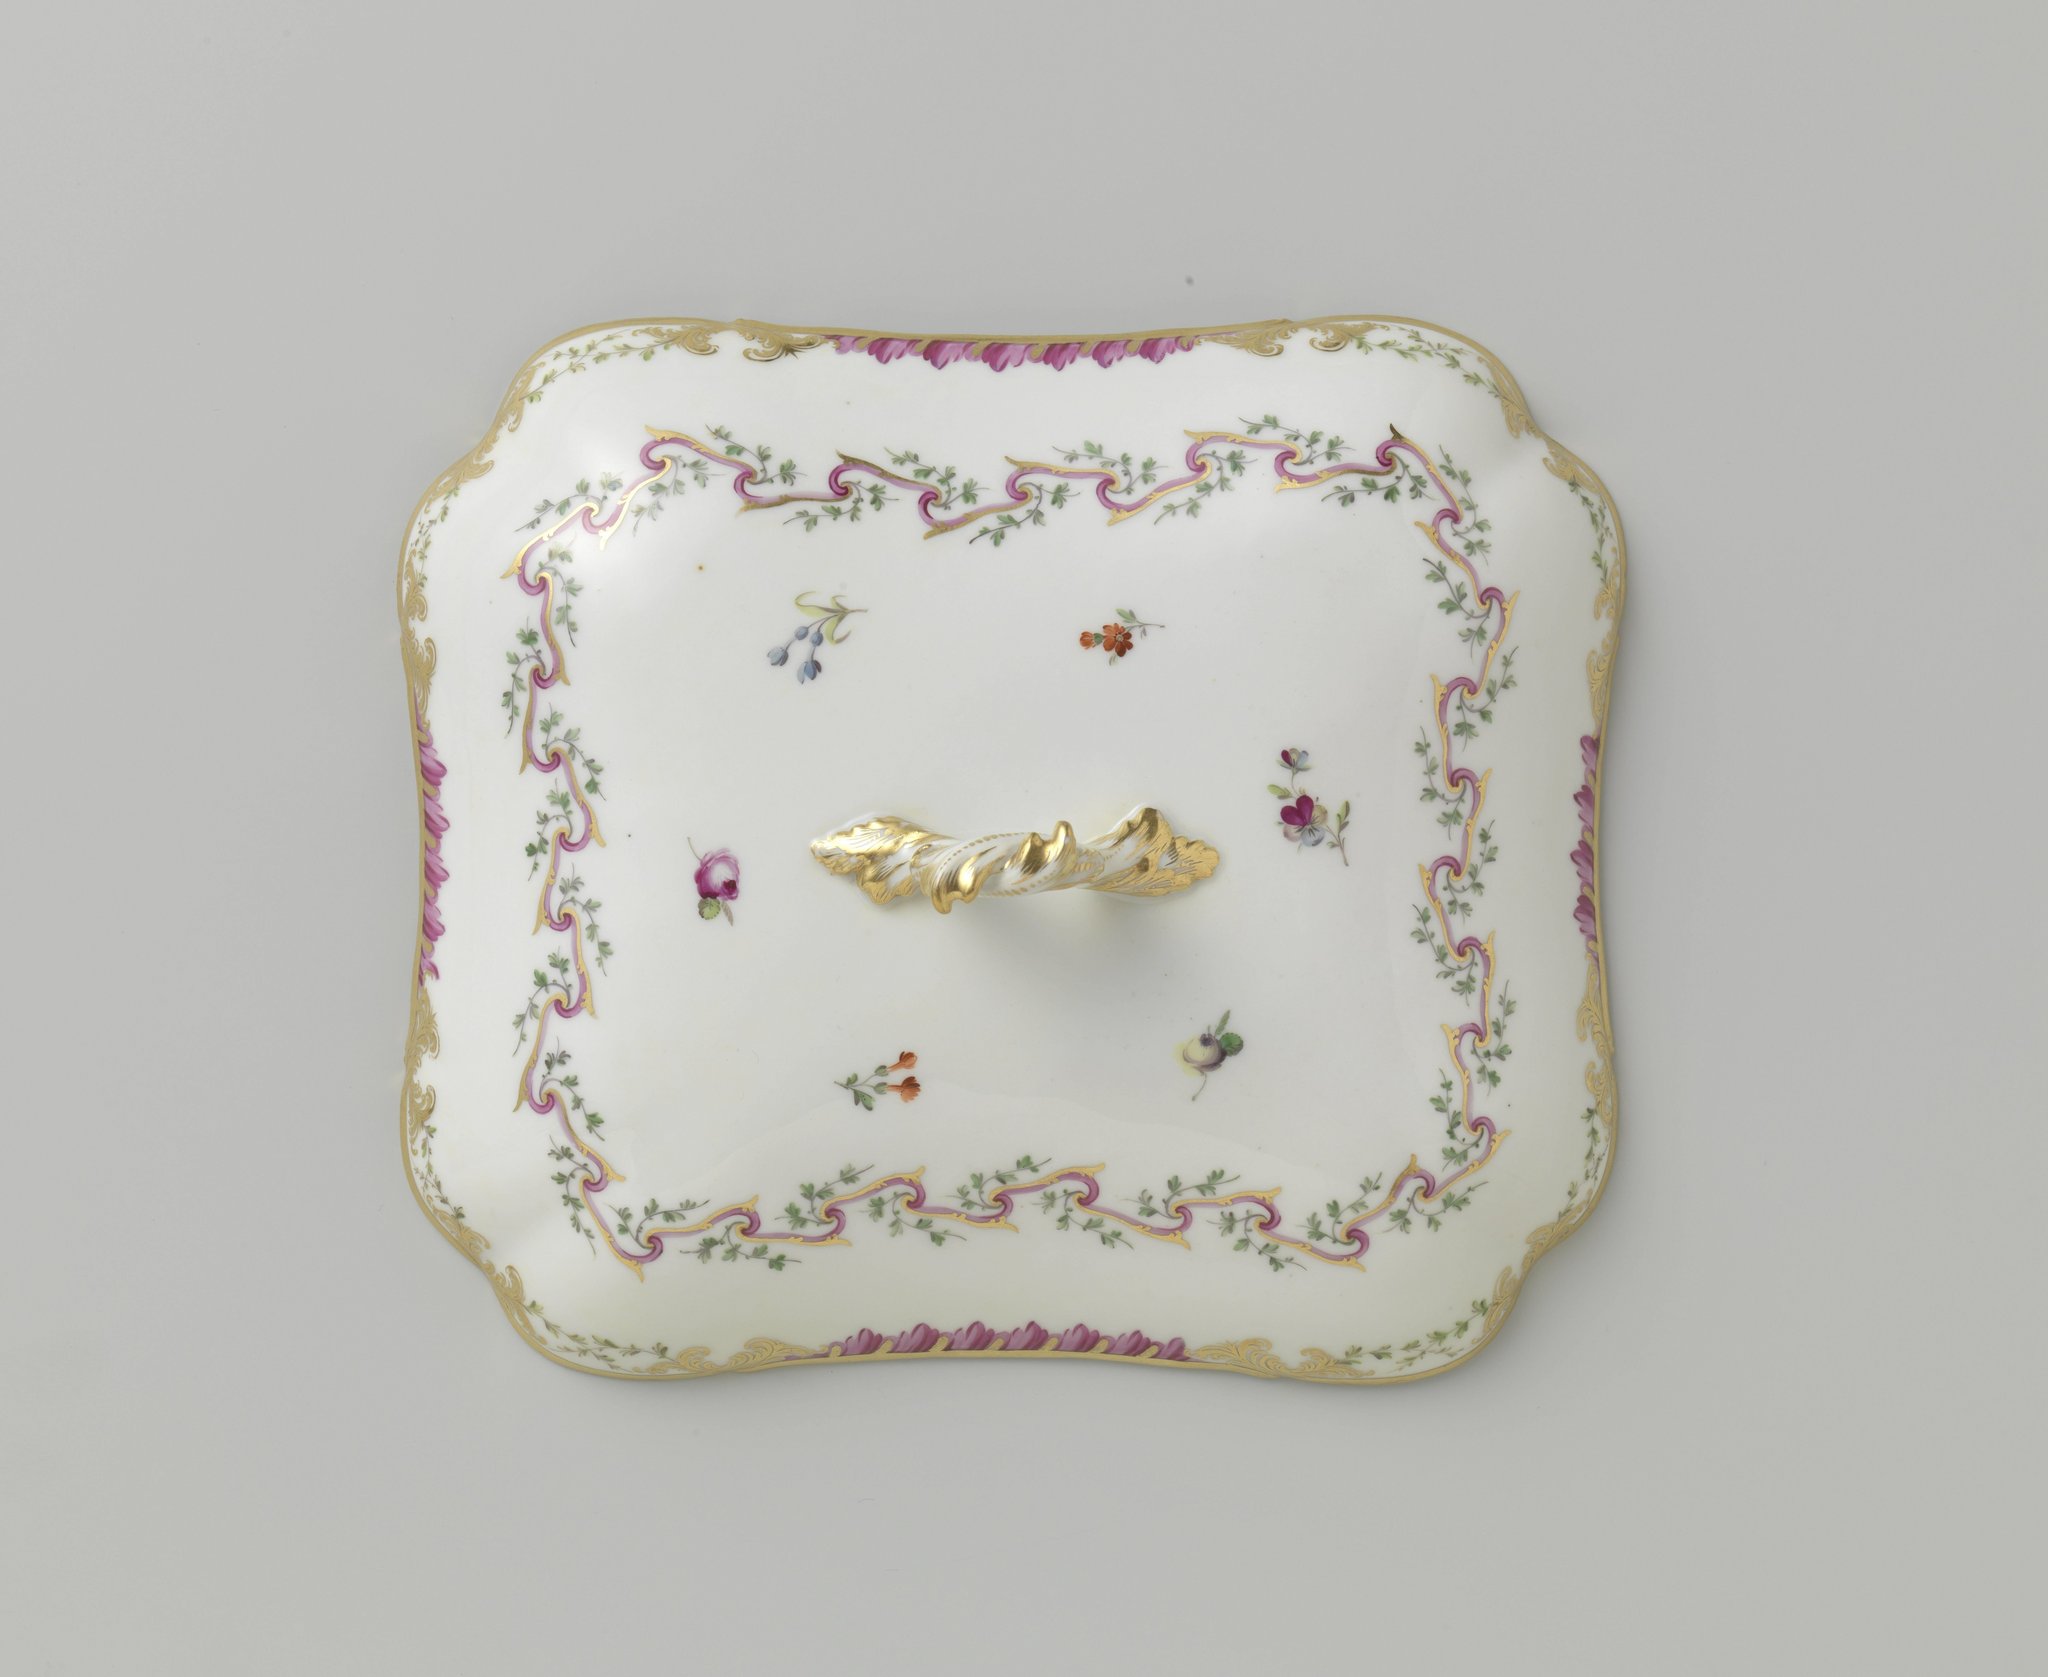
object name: vessel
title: Deksel, langwerpig, met knop, behorend bij een servies met geslingerd lintmotief met bladertakken, bloemboeketten en gestrooide bloemtakken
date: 1780-1820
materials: porcelain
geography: amsterdam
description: Deksel, langwerpig, met knop, behorend bij een servies van porselein met geslingerd motief in paars en goud met groene bladertakken, bloemboeketten en gestrooide bloemtakken. Randen lichtgegolfd met decoratie in goud met paars bladmotief waartussen groen gekruist bladmotief. Gemerkt: M.O.L. en AMSTEL.